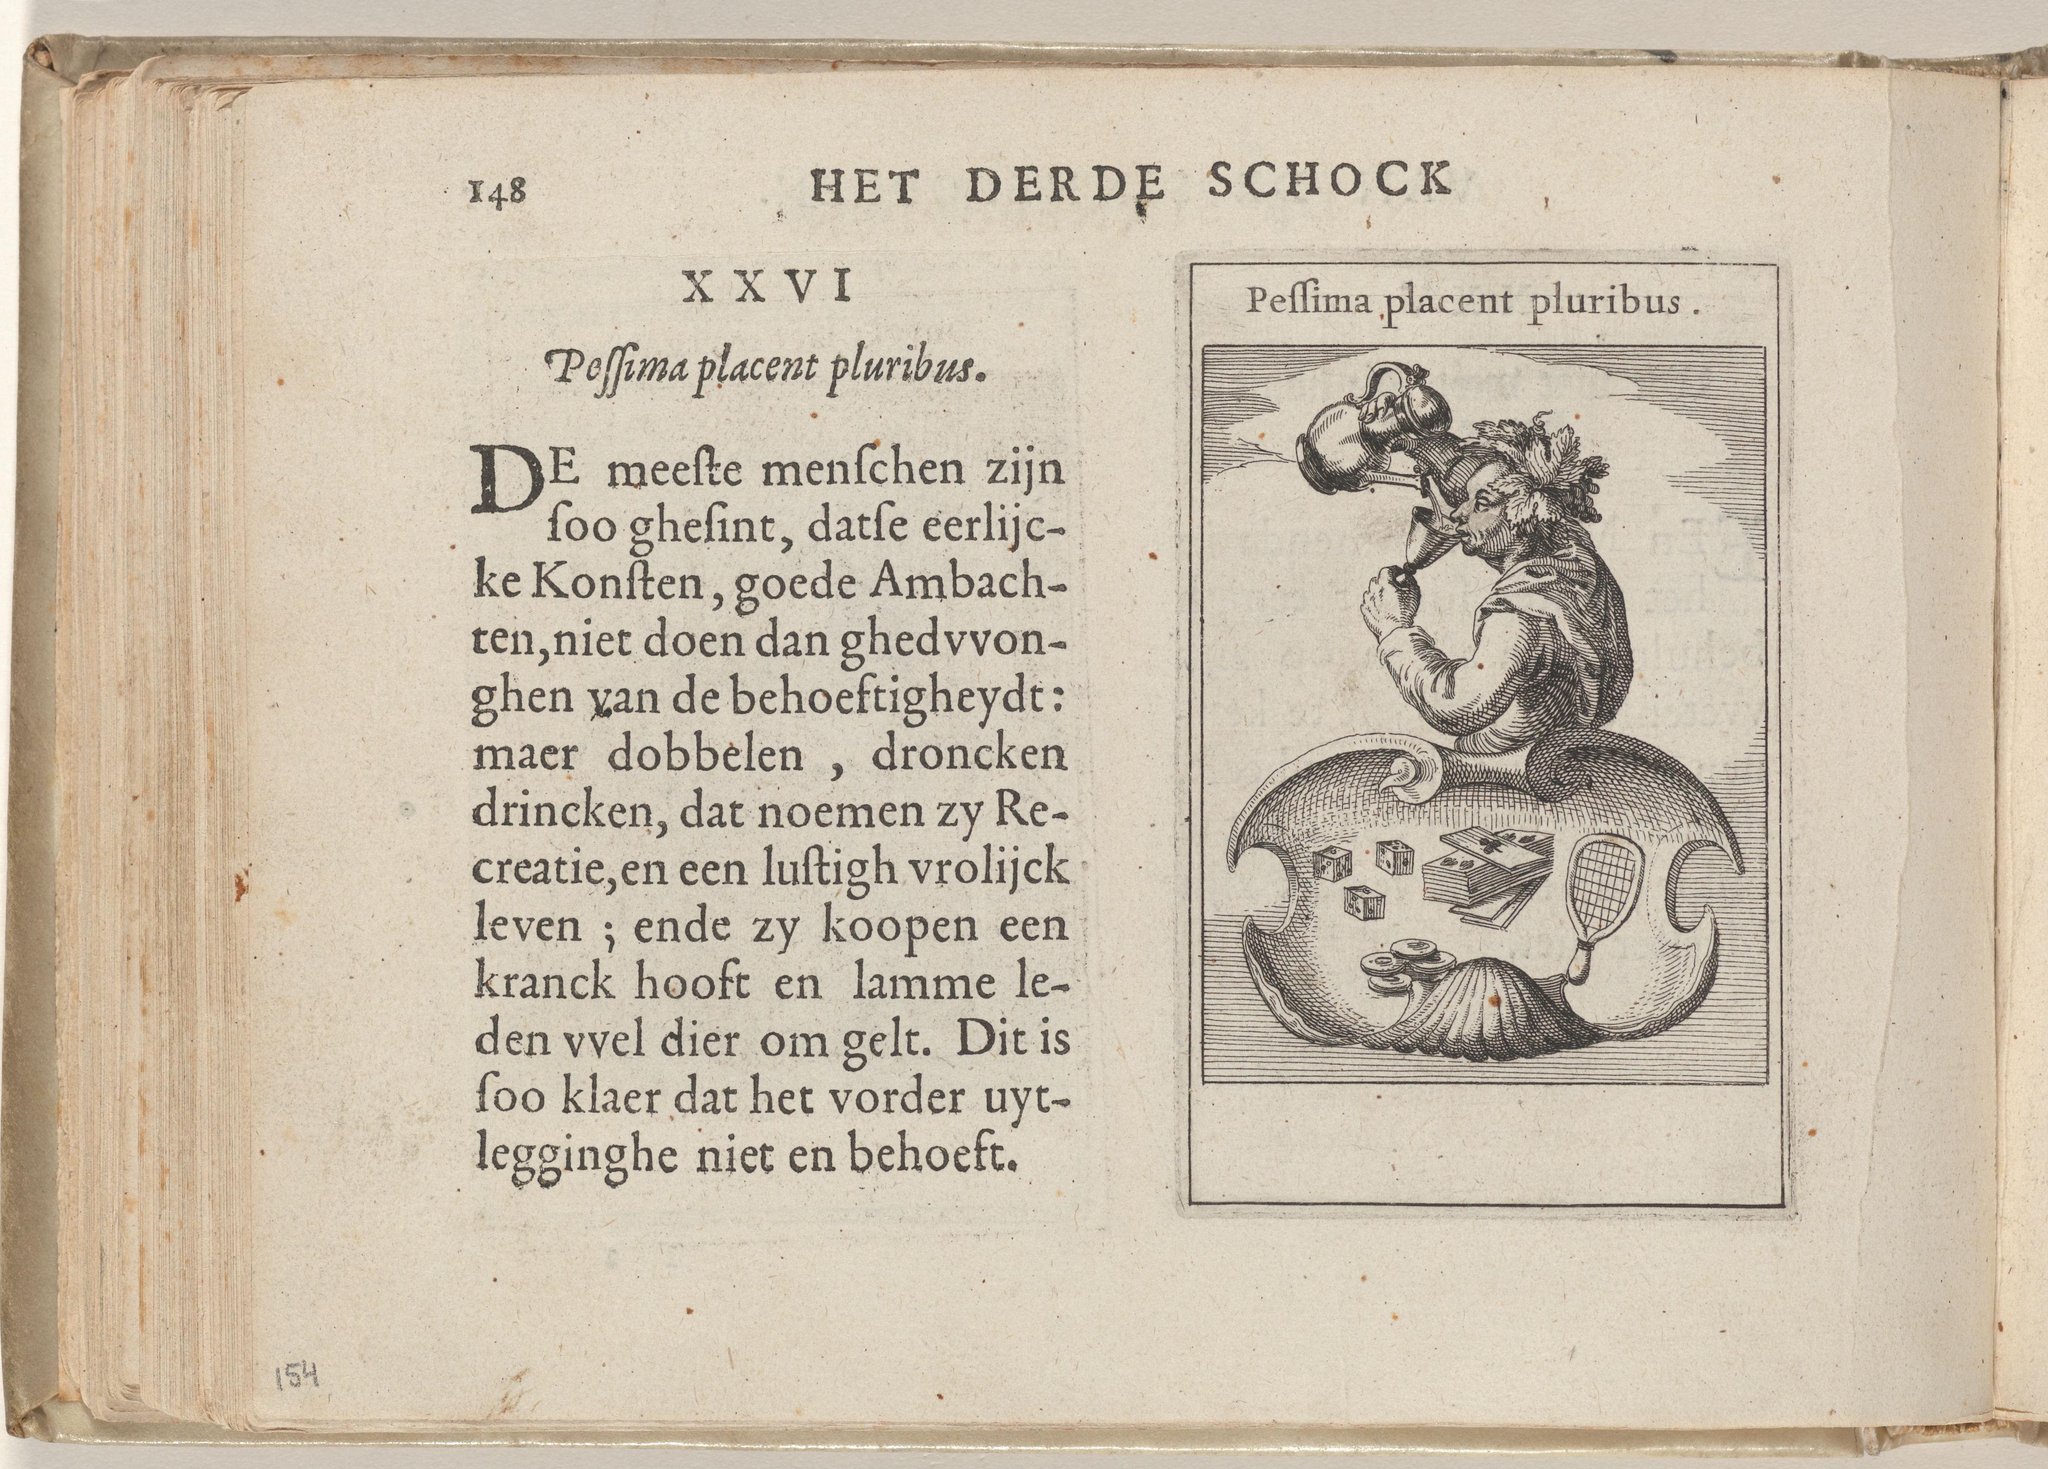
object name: print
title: XXVI Pessima placent pluribus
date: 1614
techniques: engraving, printing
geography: the hague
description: XXVI Pessima placent pluribus. Derde schok. Onderdeel van 'Sinnepoppen', R. Visscher, 1614.